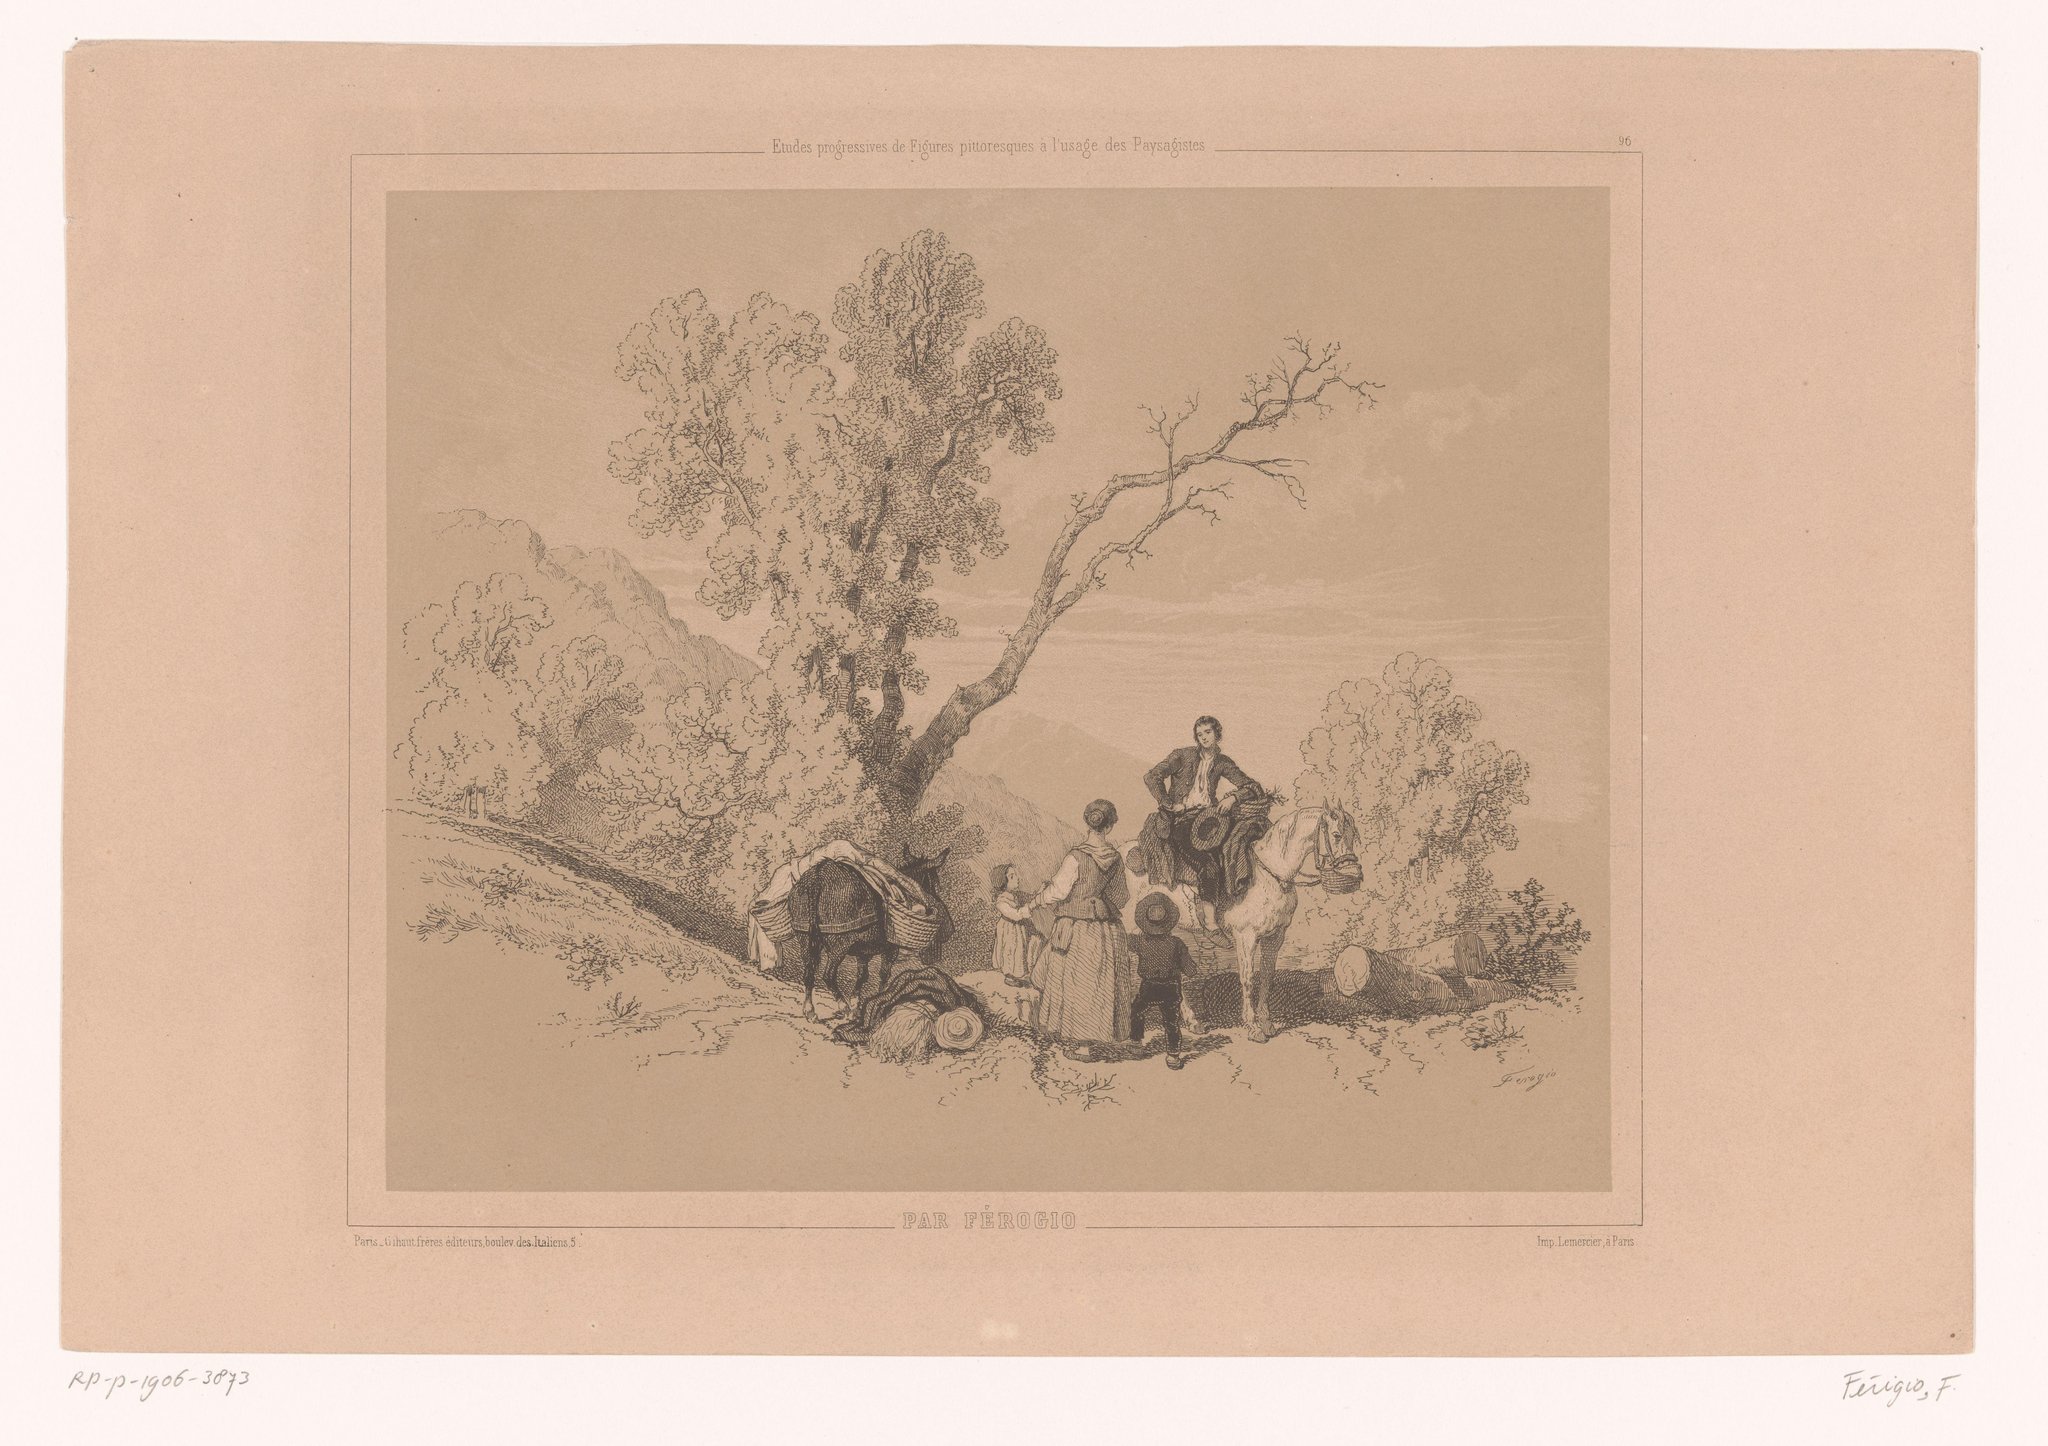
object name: print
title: Rustende familie op reis in een berglandschap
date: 1846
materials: paper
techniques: pen lithography, tone lithography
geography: paris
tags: the family travelling, on holiday, (traveller) resting in the open air, mountains (+ landscape with figures, staffage)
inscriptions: collector's mark: Lugt 2228a